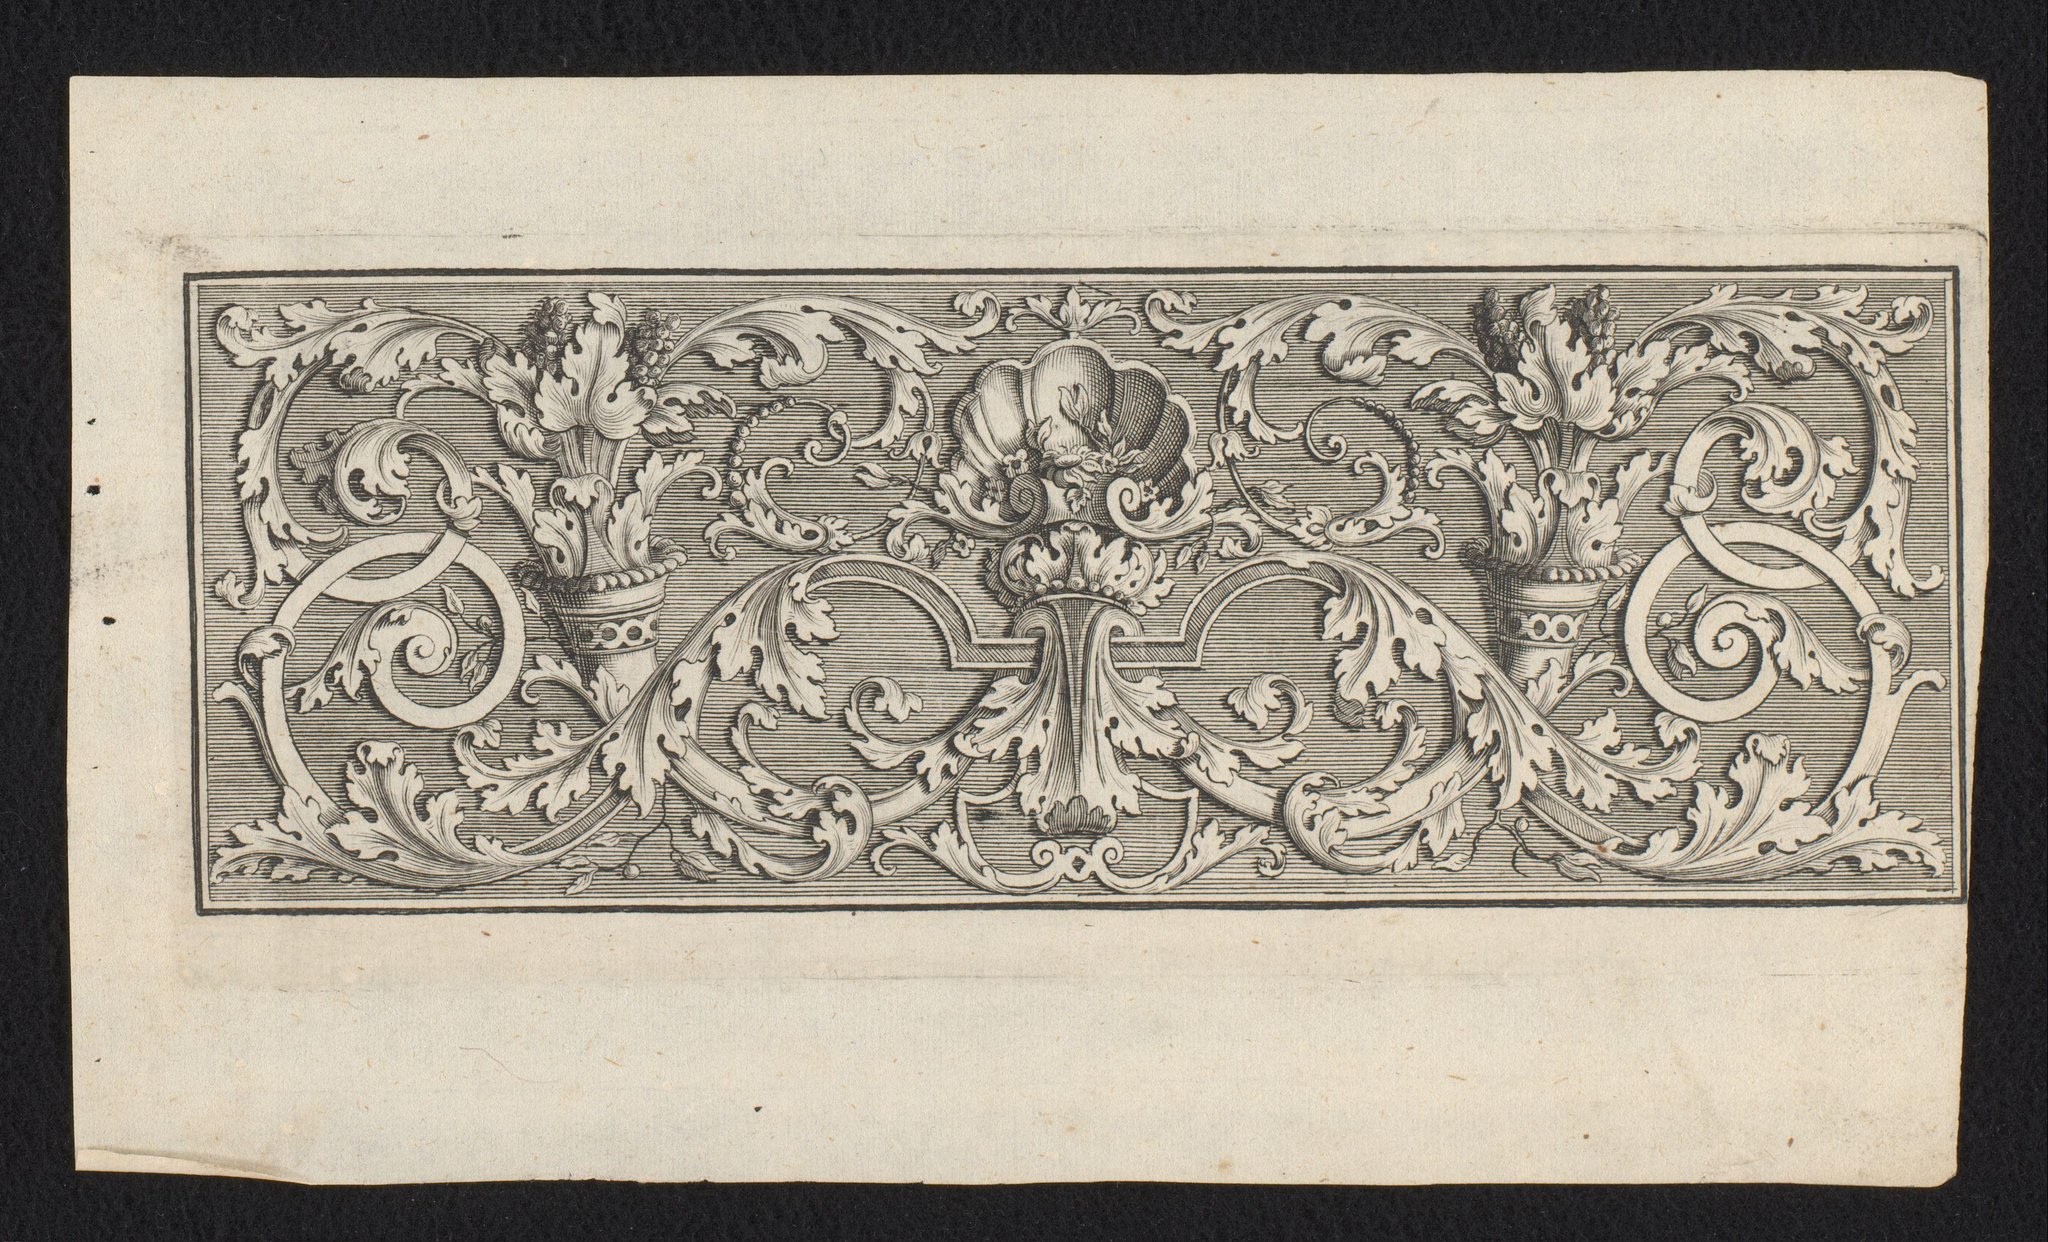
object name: ornament print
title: Neu-inventirtes Laub und Bandl Werk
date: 1705-1710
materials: paper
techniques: engraving, etching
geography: nuremberg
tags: 'laub- und bandelwerk' ~ ornament, scallop, shell ~ ornament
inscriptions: collector's mark: Lugt 2228, collector's mark: Lugt 2760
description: Vlechtwerk met bladmotieven. In het midden een schelp geflankeerd door twee hoorns waaruit gebladerte ontspruit.